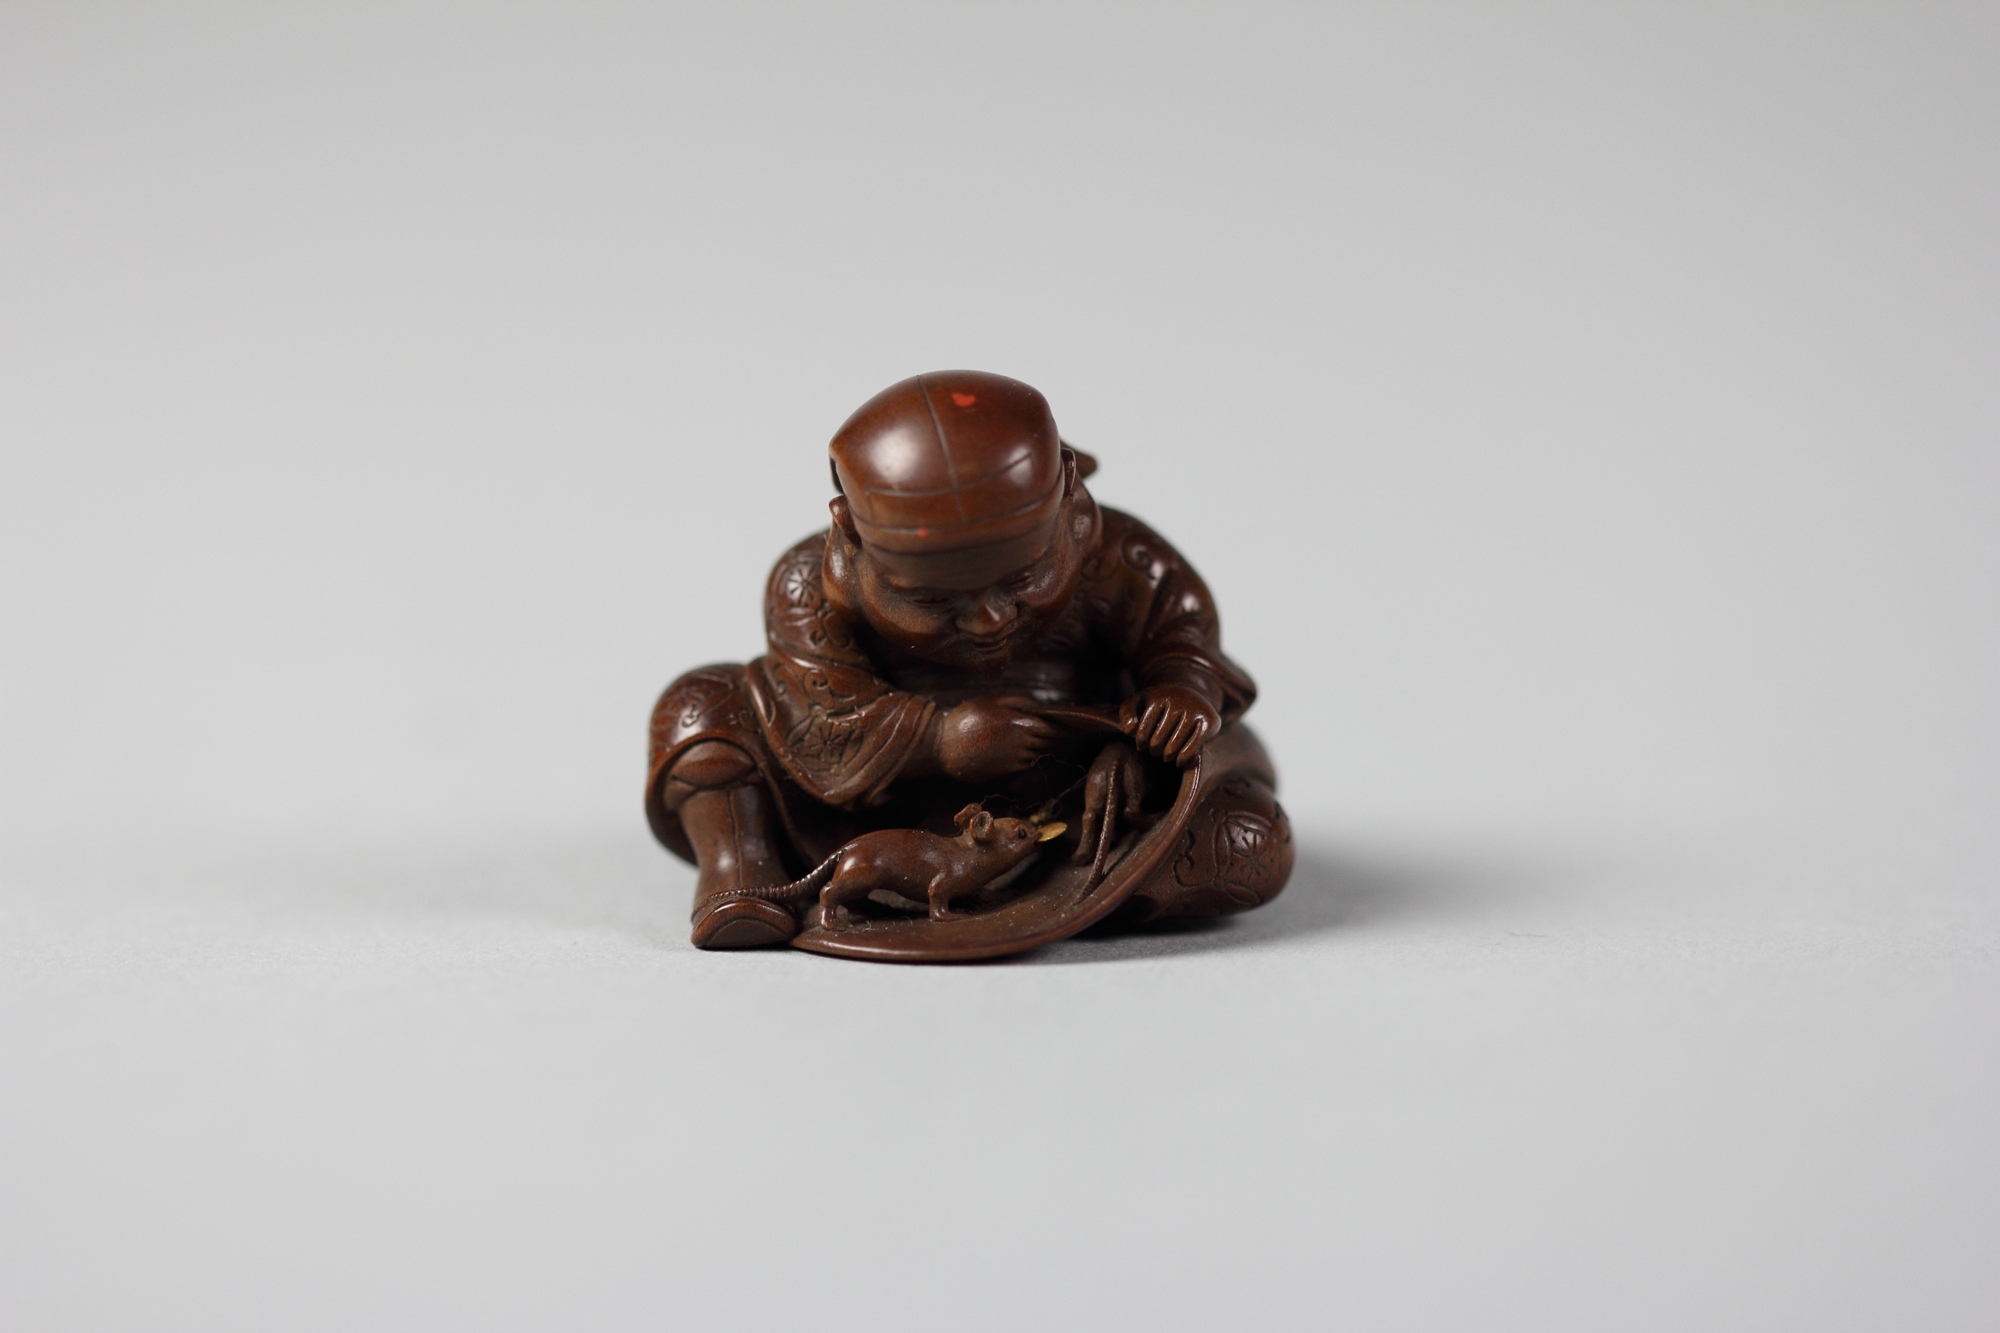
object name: netsuke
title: Netsuke of Daikoku and Bag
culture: japanese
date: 1801-1900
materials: wood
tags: men,mice